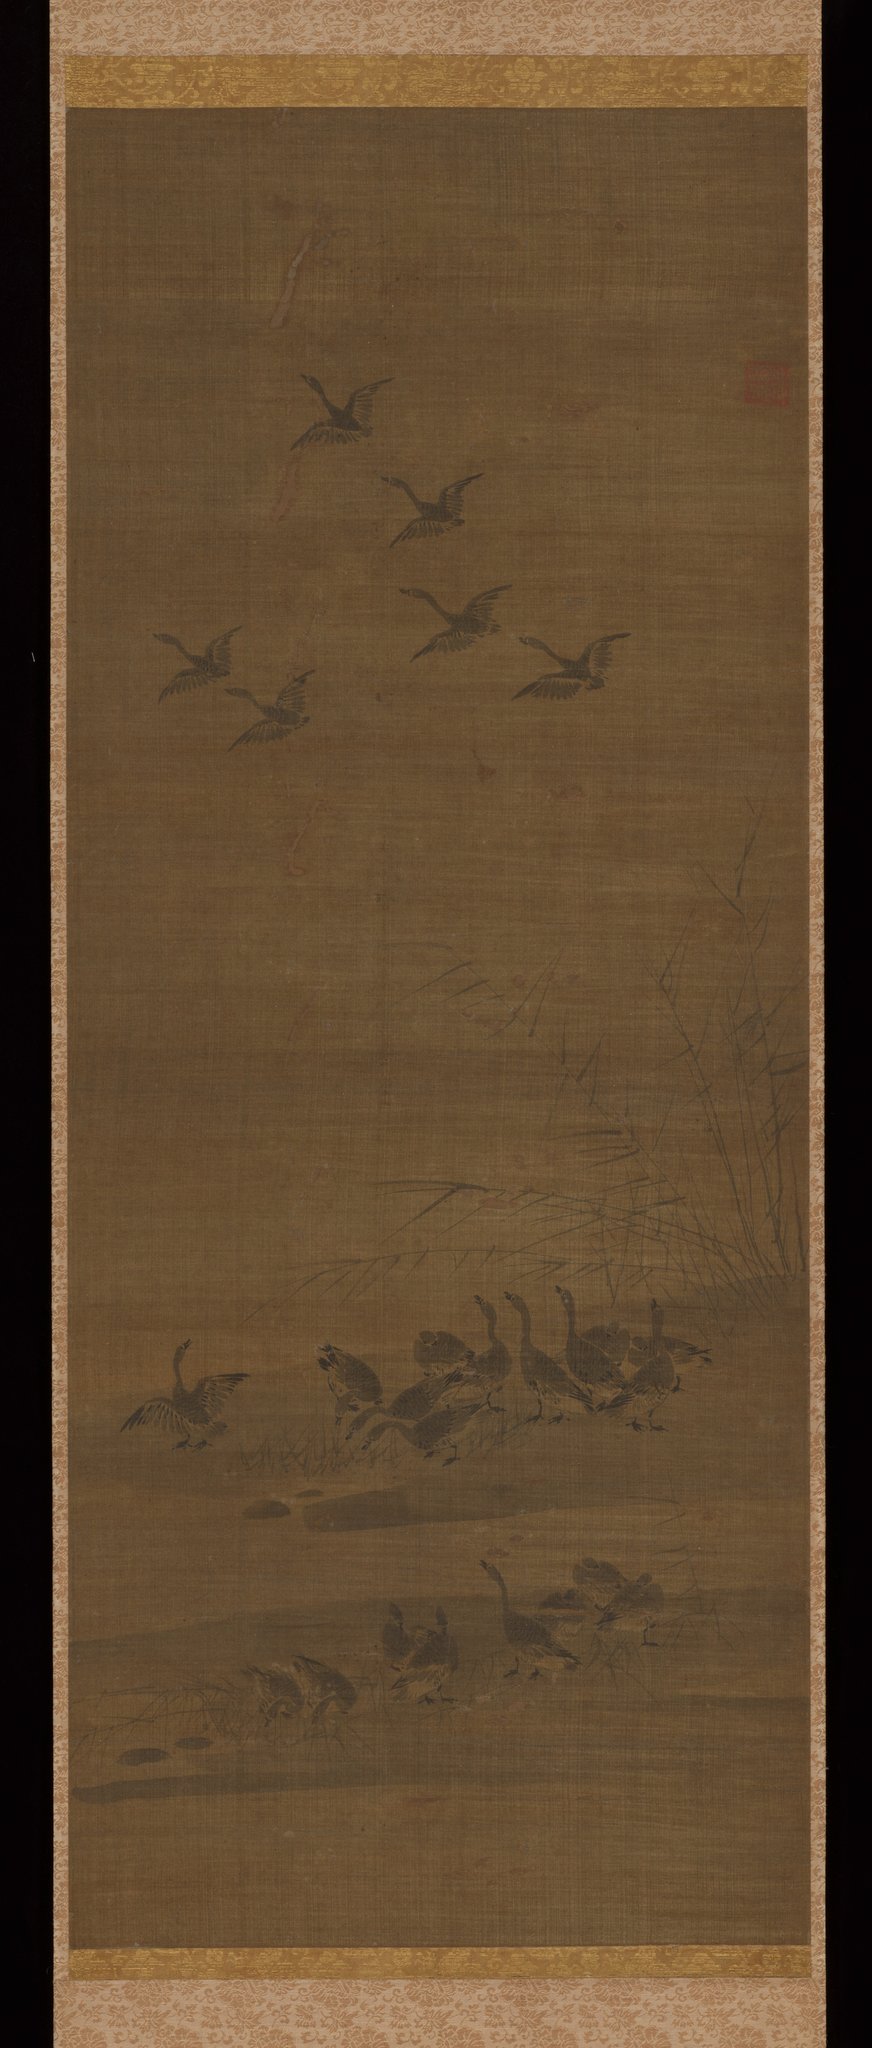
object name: hanging scroll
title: Reeds and Geese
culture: japanese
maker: tesshū tokusai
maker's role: artist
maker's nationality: japanese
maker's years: 1342-1366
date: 1343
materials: ink, silk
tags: geese